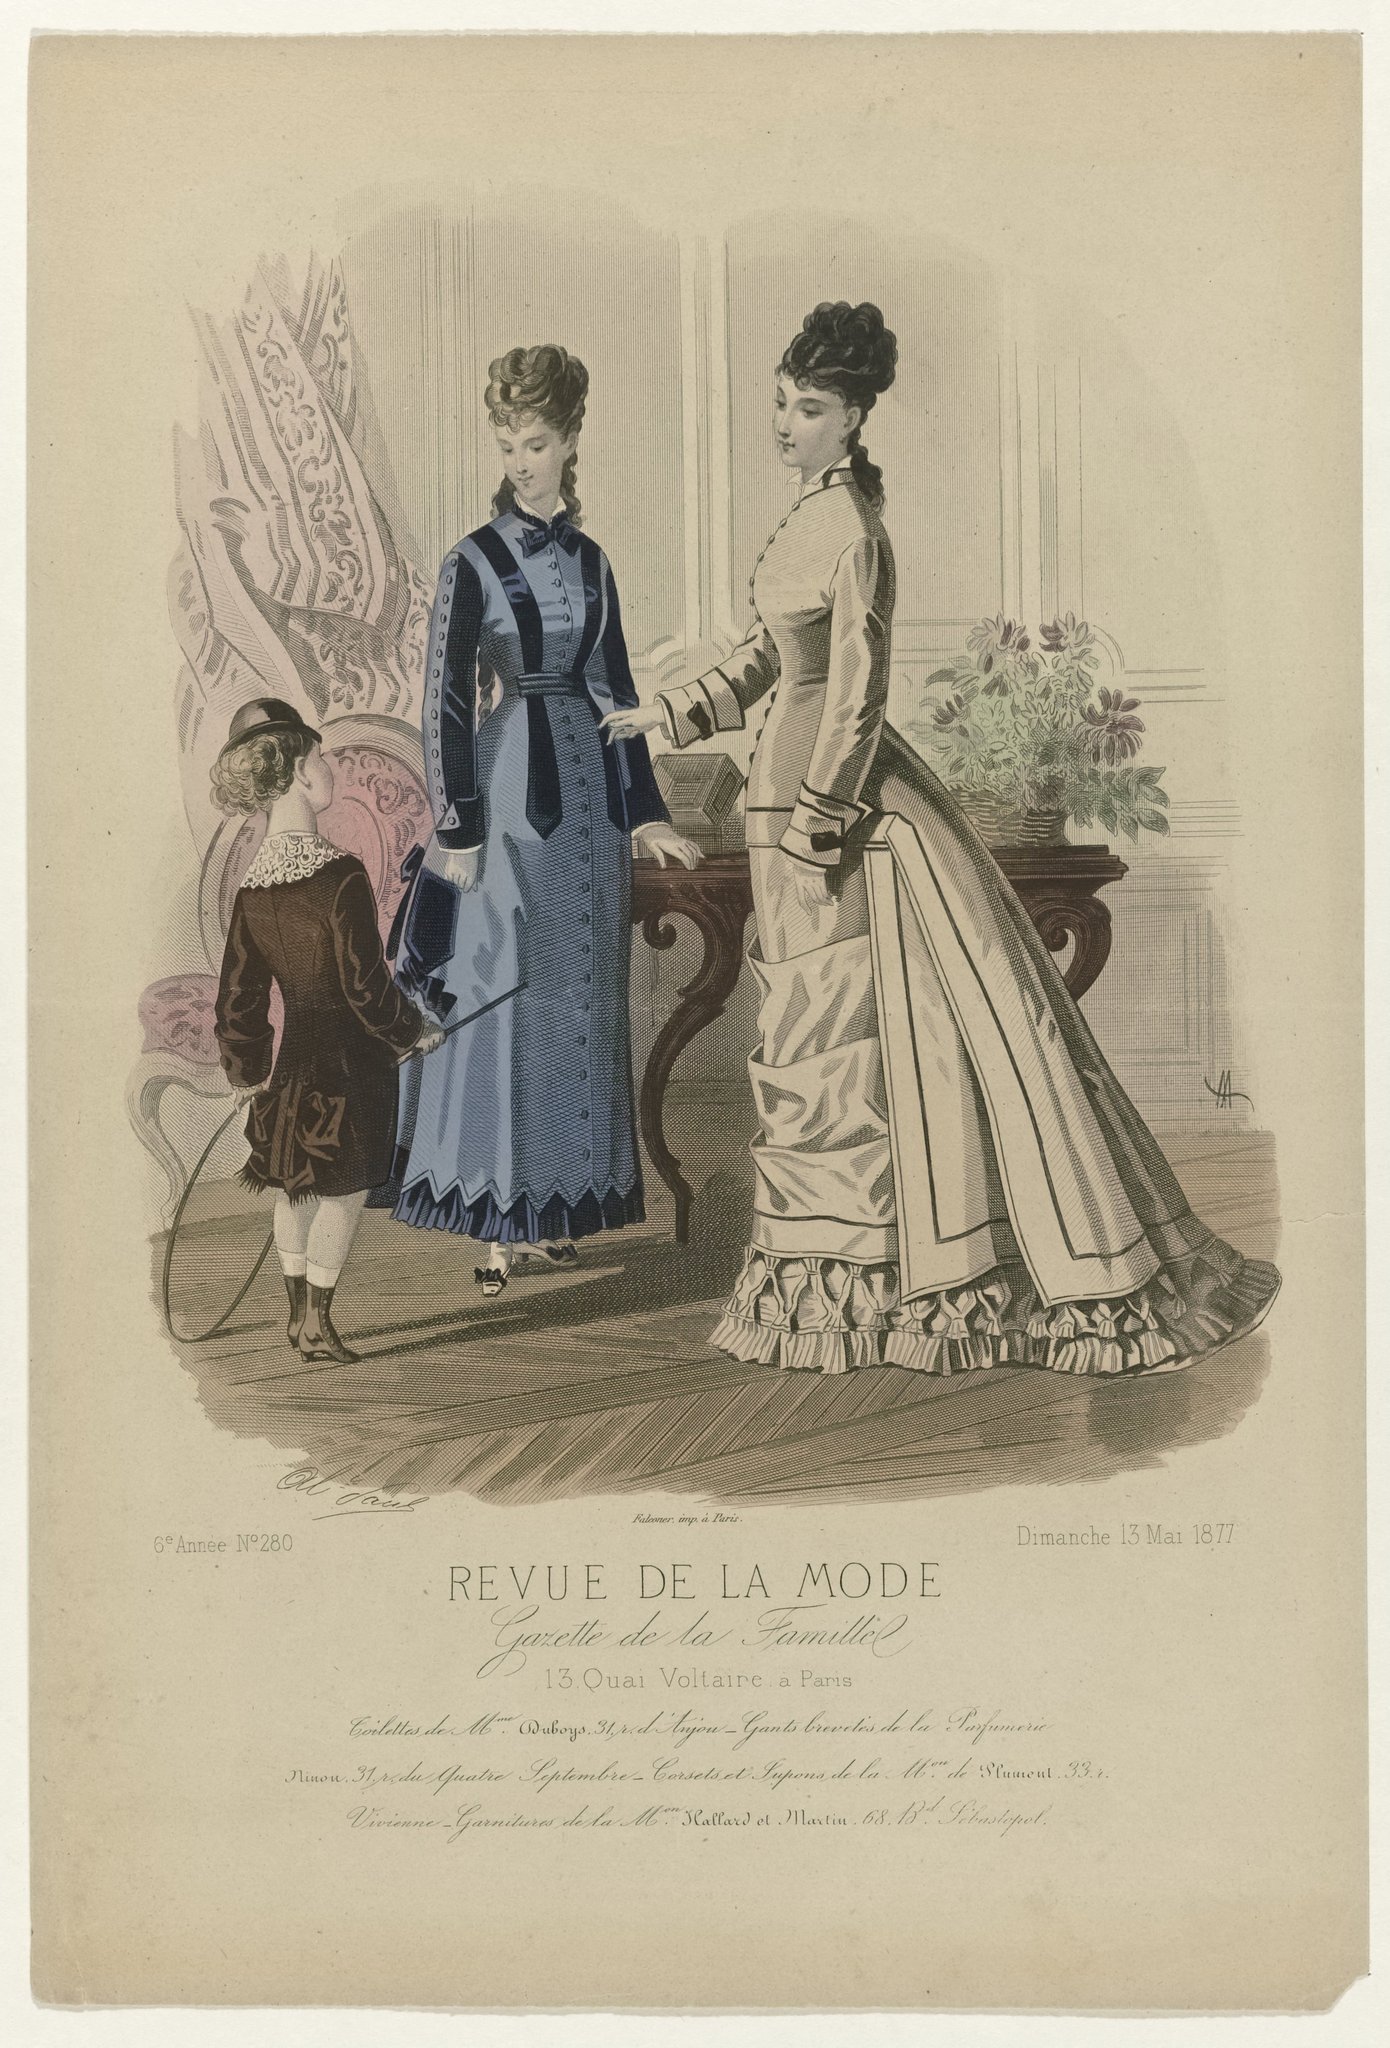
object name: fashion print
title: Revue de la Mode, Gazette de la Famille, dimanche 13 mai 1877, 6e année, No. 280: Toilettes de Mme Duboys (...)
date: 1877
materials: paper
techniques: engraving, hand coloring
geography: paris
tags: boots (+ girls' clothes), head-gear: bowler hat (+ girls' clothes), fashion plates, shoes, sandals (+ women's clothes), skirt (+ women's clothes), dress, gown (+ women's clothes), (bowling a) hoop, dress, gown (+ girls' clothes)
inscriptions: address: ‘13, Quai Voltaire à Paris’, title: ‘REVUE DE LA MODE / Gazette de la Famille’, caption: ‘Toilettes de Mme Duboys, 31,r. d'Anjou_Gants brevetés de la Parfumerie Ninon. 31. r. du Quatre Septembre_Corsets et Jupons de la M.on de Plument. 33. r. Vivienne_Garnitures de la M.on Hallardet Martin 68.B.d Sébastopol.’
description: Twee vrouwen en een meisje in een interieur, volgens het onderschrift gekleed in japonnen van Duboys. Hieronder enkele regels reclametekst voor verschillende producten. Prent uit het modetijdschrift Revue de la Mode (1872-1913).